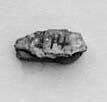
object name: fragment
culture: burmese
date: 1902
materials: jade